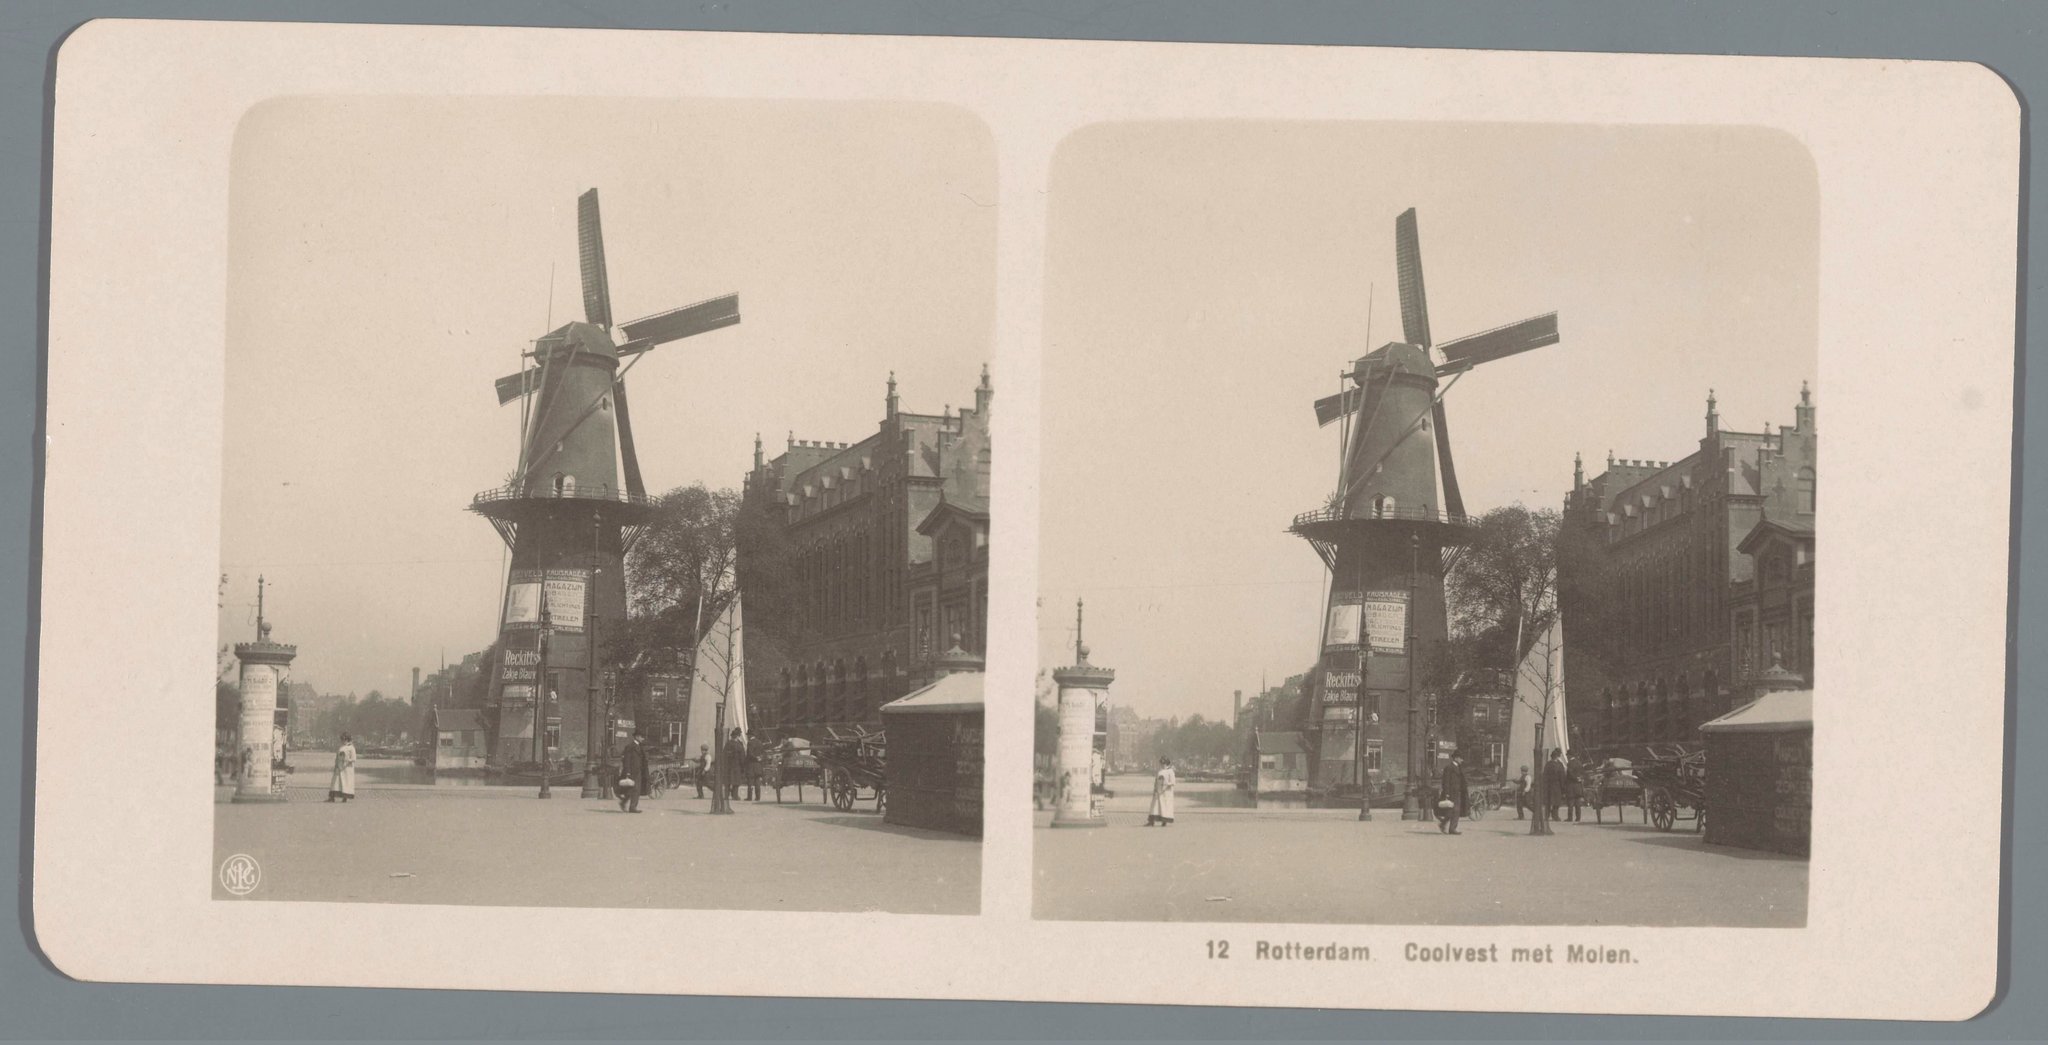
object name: stereograph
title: Rotterdam. Coolvest met molen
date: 1900-1910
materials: cardboard, photographic support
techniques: gelatin silver print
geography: rotterdam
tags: windmill in landscape, canals, waters (in city)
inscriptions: inscription: ‘NPG’, number: ‘12’